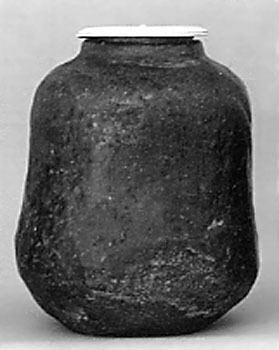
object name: tea jar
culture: japanese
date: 1701-1800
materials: clay, glaze